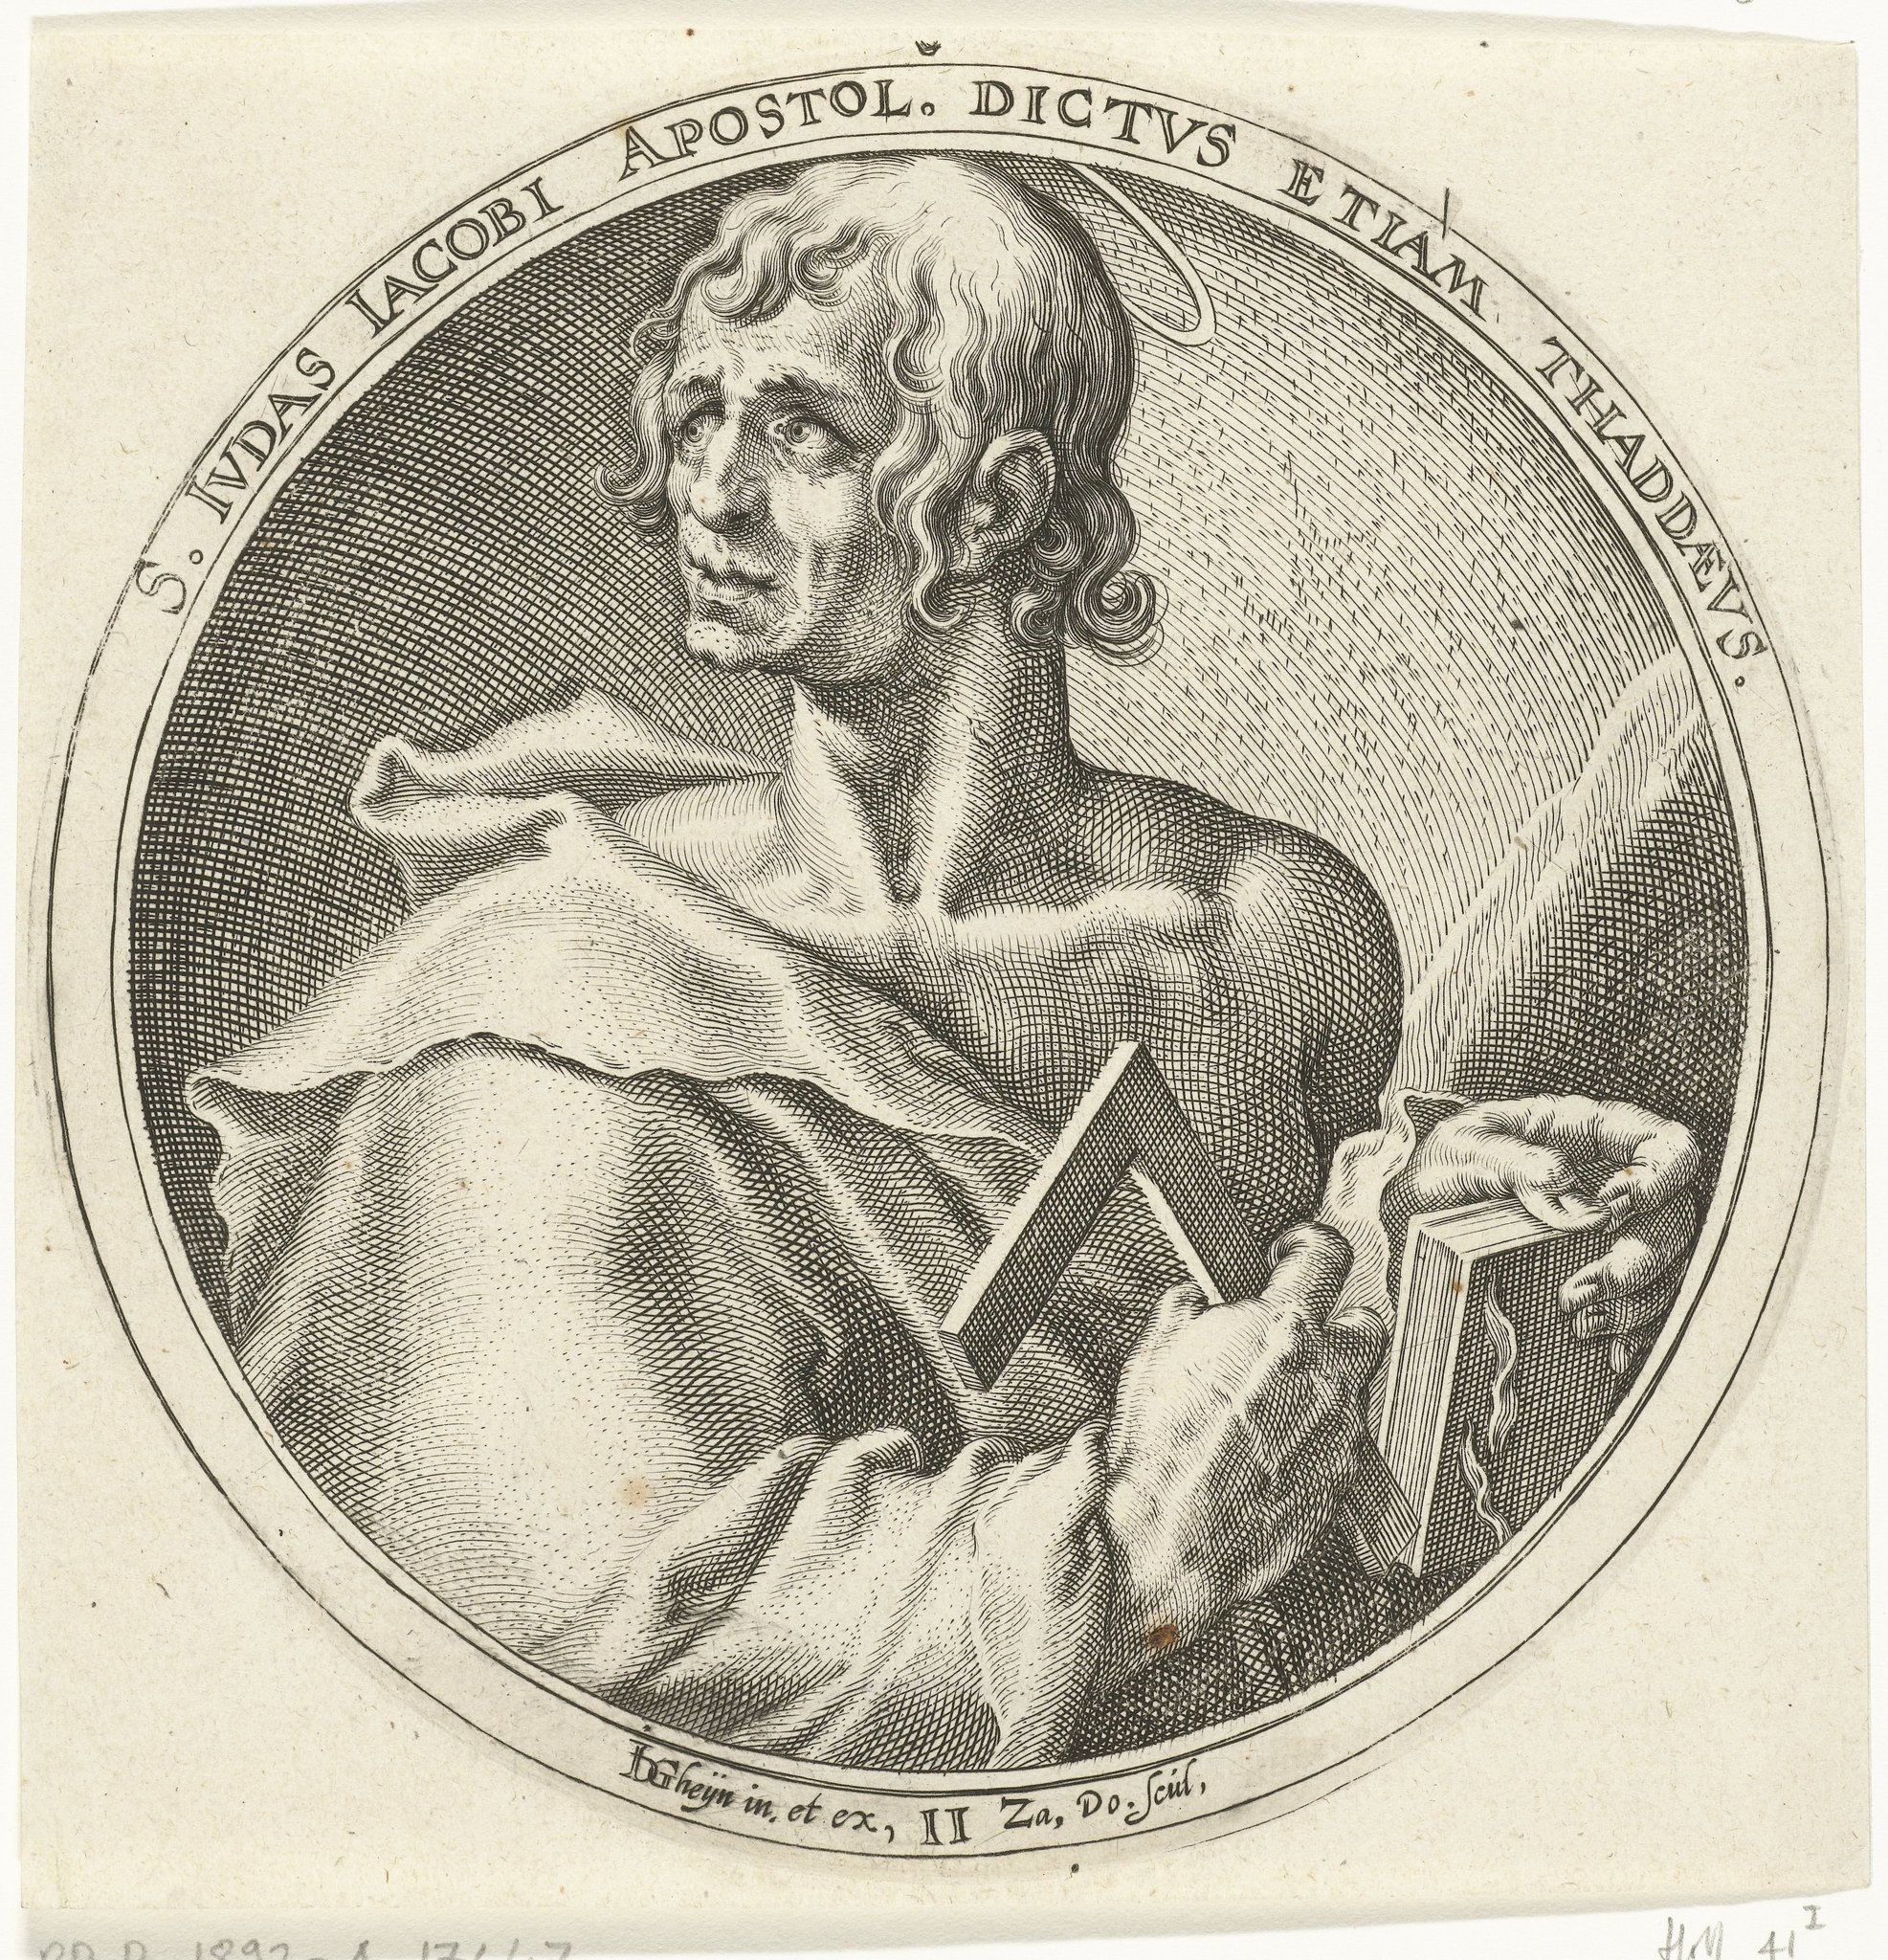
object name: print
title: Christus, de apostelen en de H. Paulus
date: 1596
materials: paper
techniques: engraving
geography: leiden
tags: the apostle jude thaddaeus; possible attributes: book, club, halberd, scroll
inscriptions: collector's mark: Lugt 2228